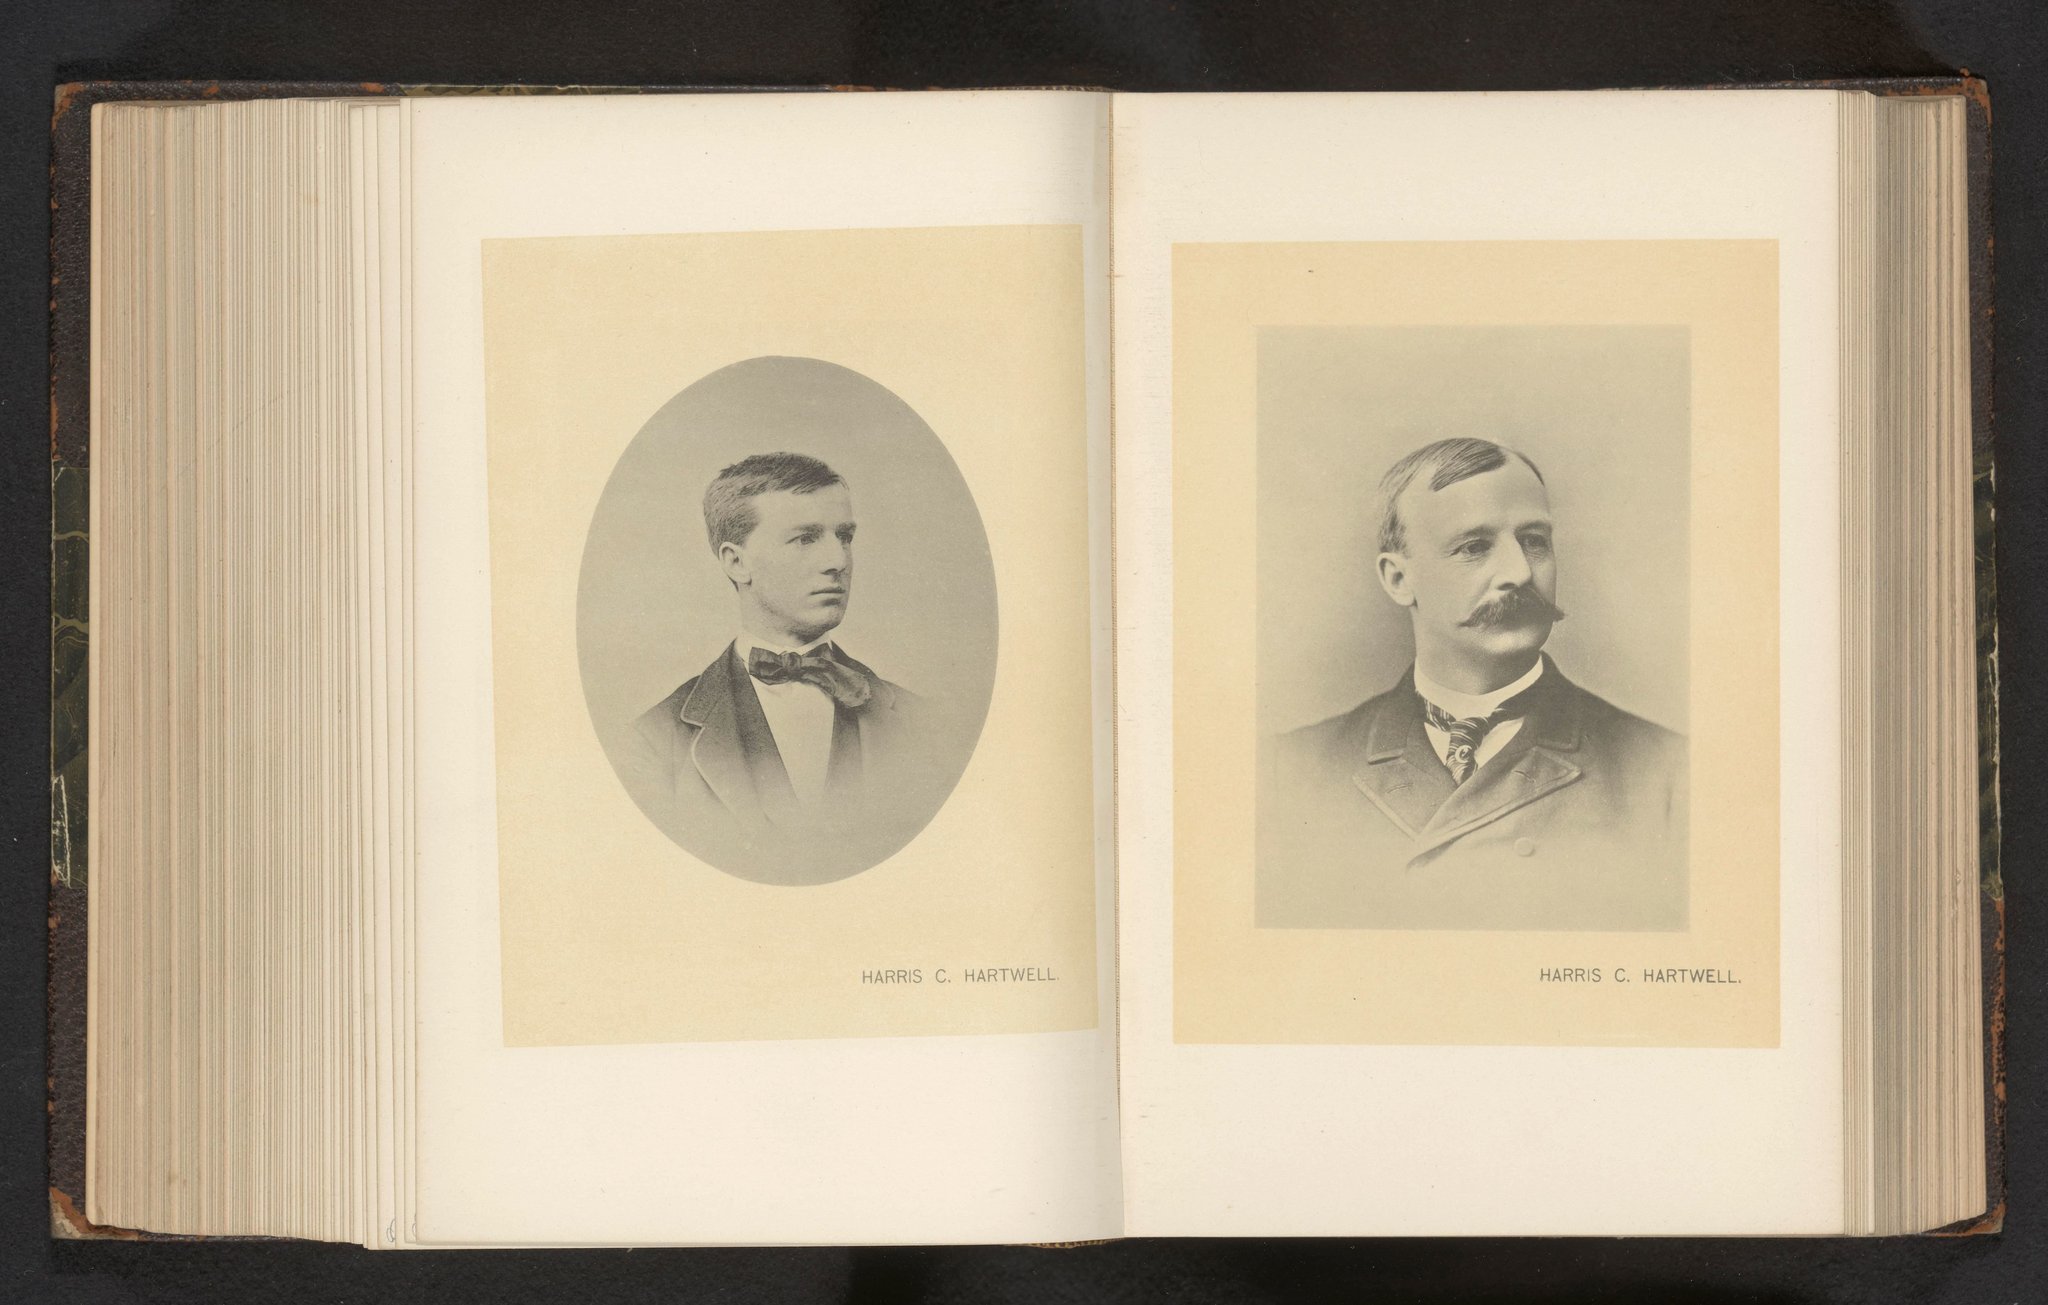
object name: page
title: Harris C. Hartwell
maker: Anonymous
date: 1869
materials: paper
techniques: photoaquatint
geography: boston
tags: adult man